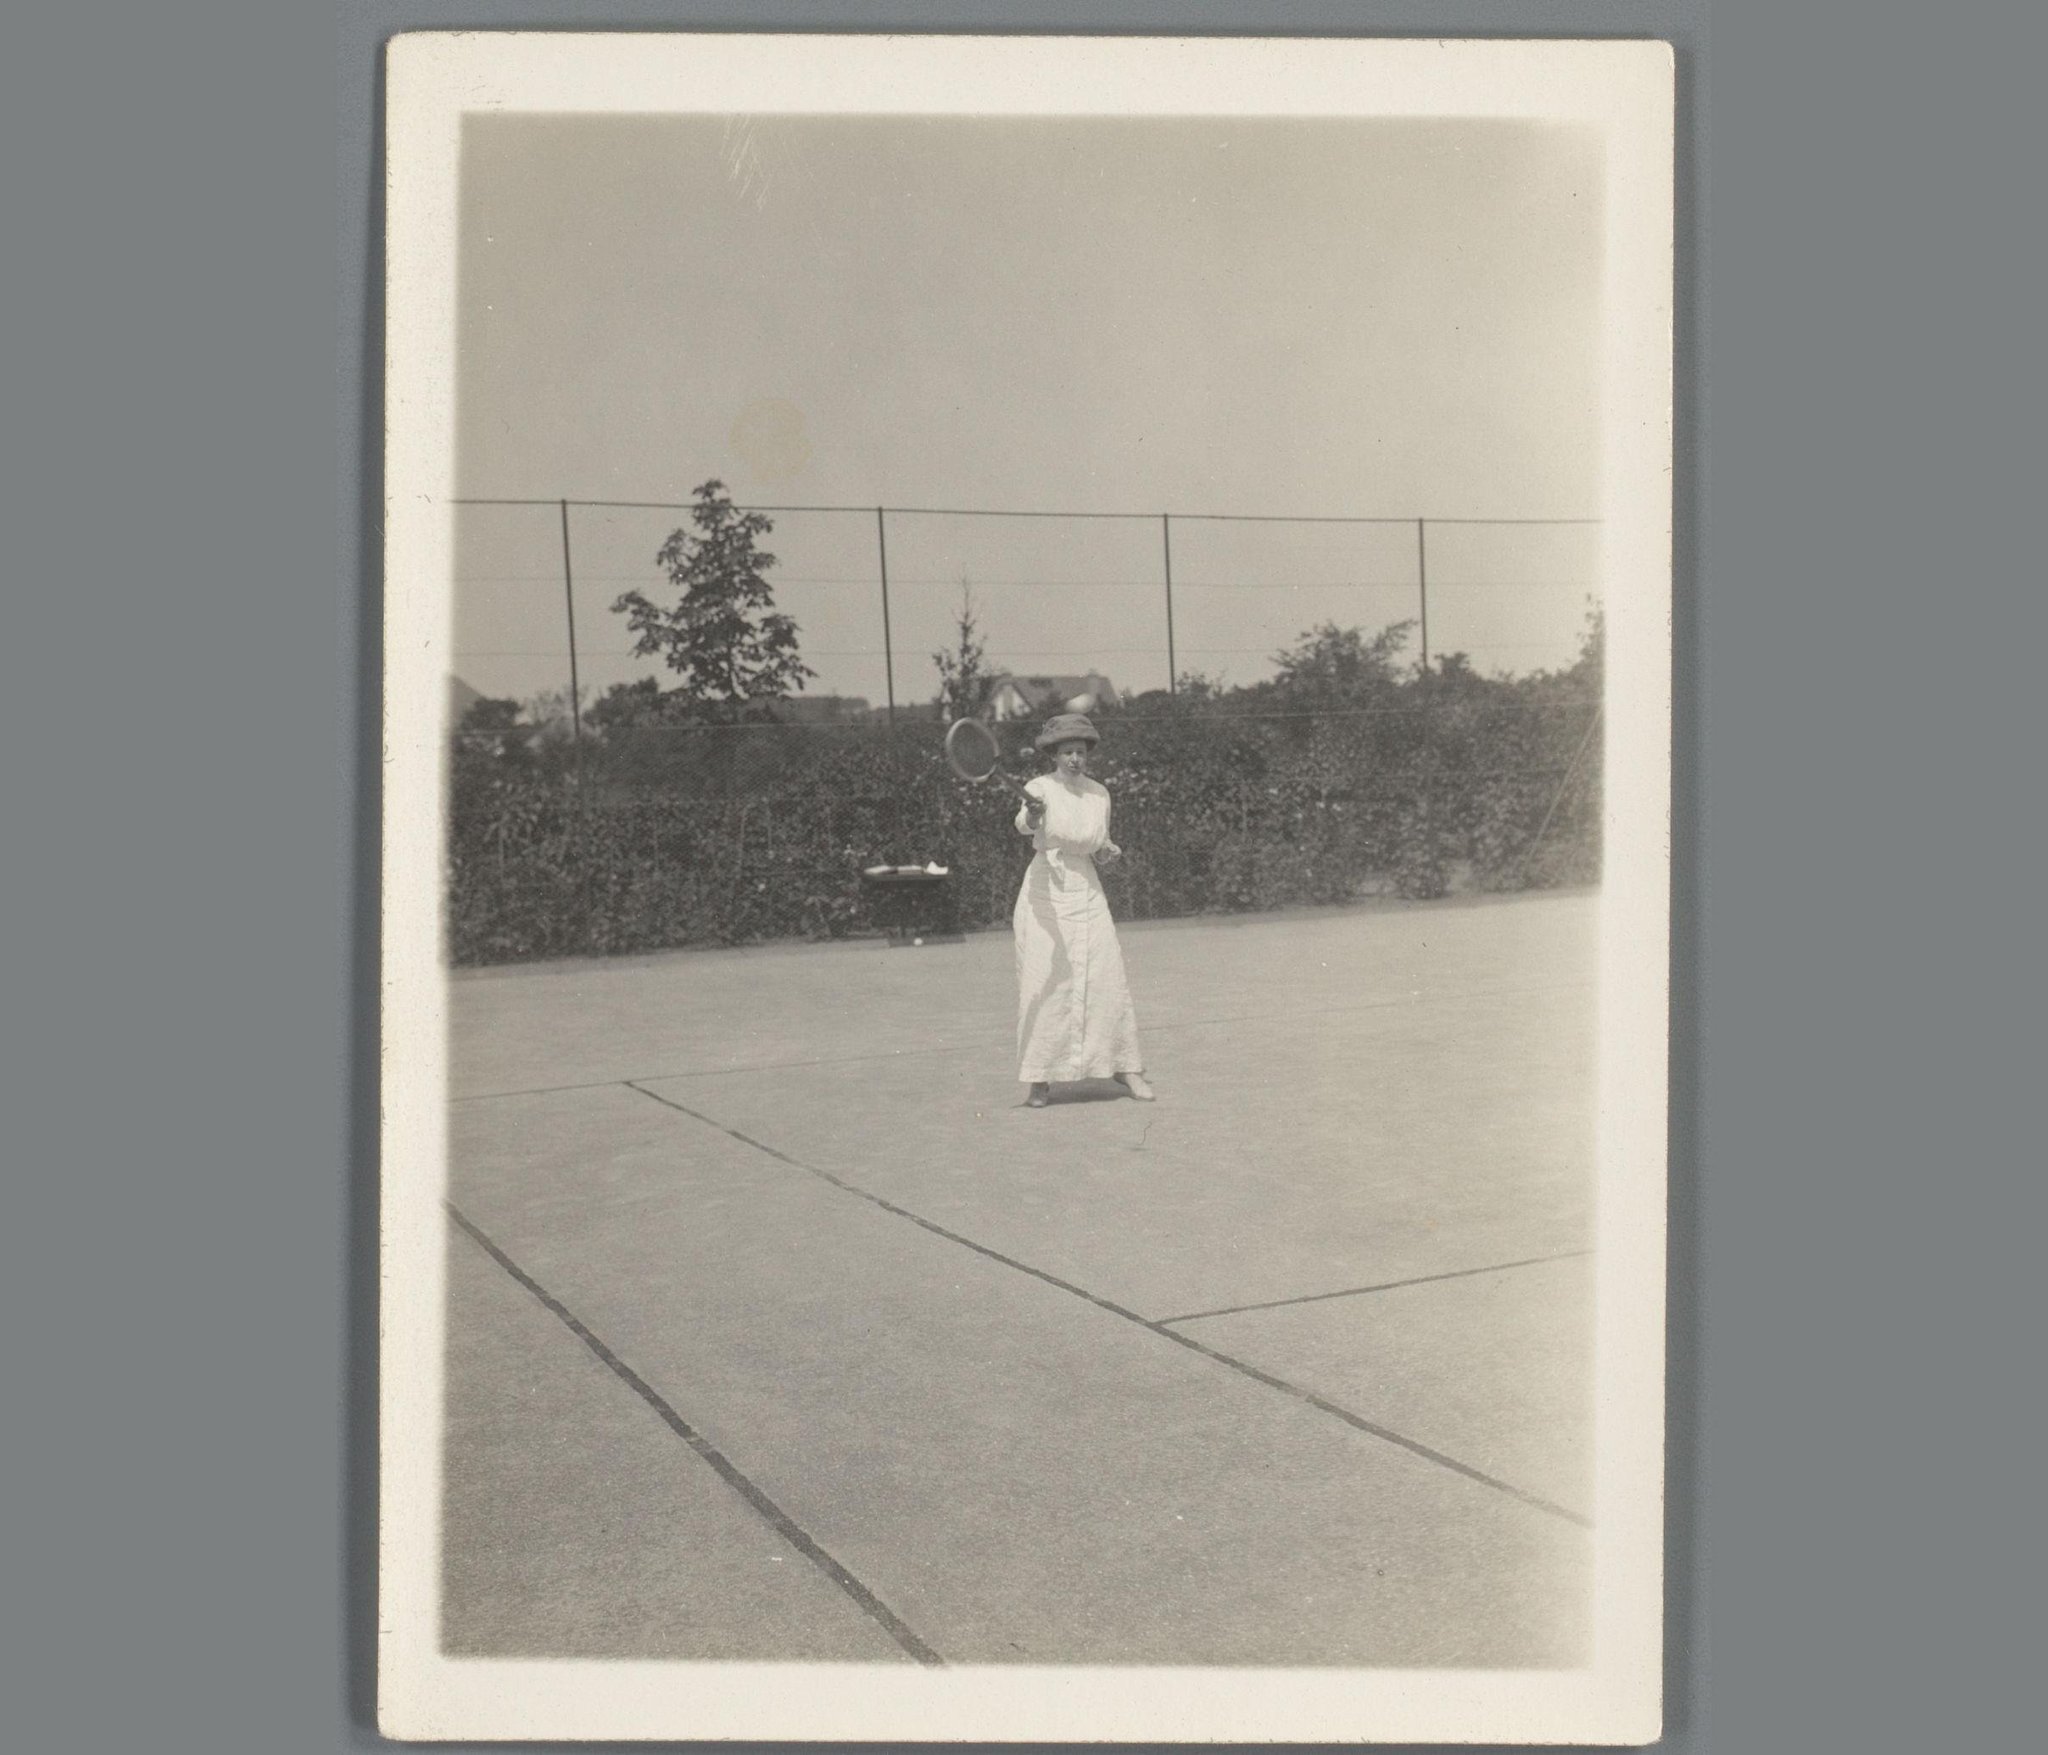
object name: photograph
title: Tennissende vrouw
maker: Anonymous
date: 1900-1920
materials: paper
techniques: gelatin silver print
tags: tennis, lawn-tennis, adult woman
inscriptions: number: ‘70’